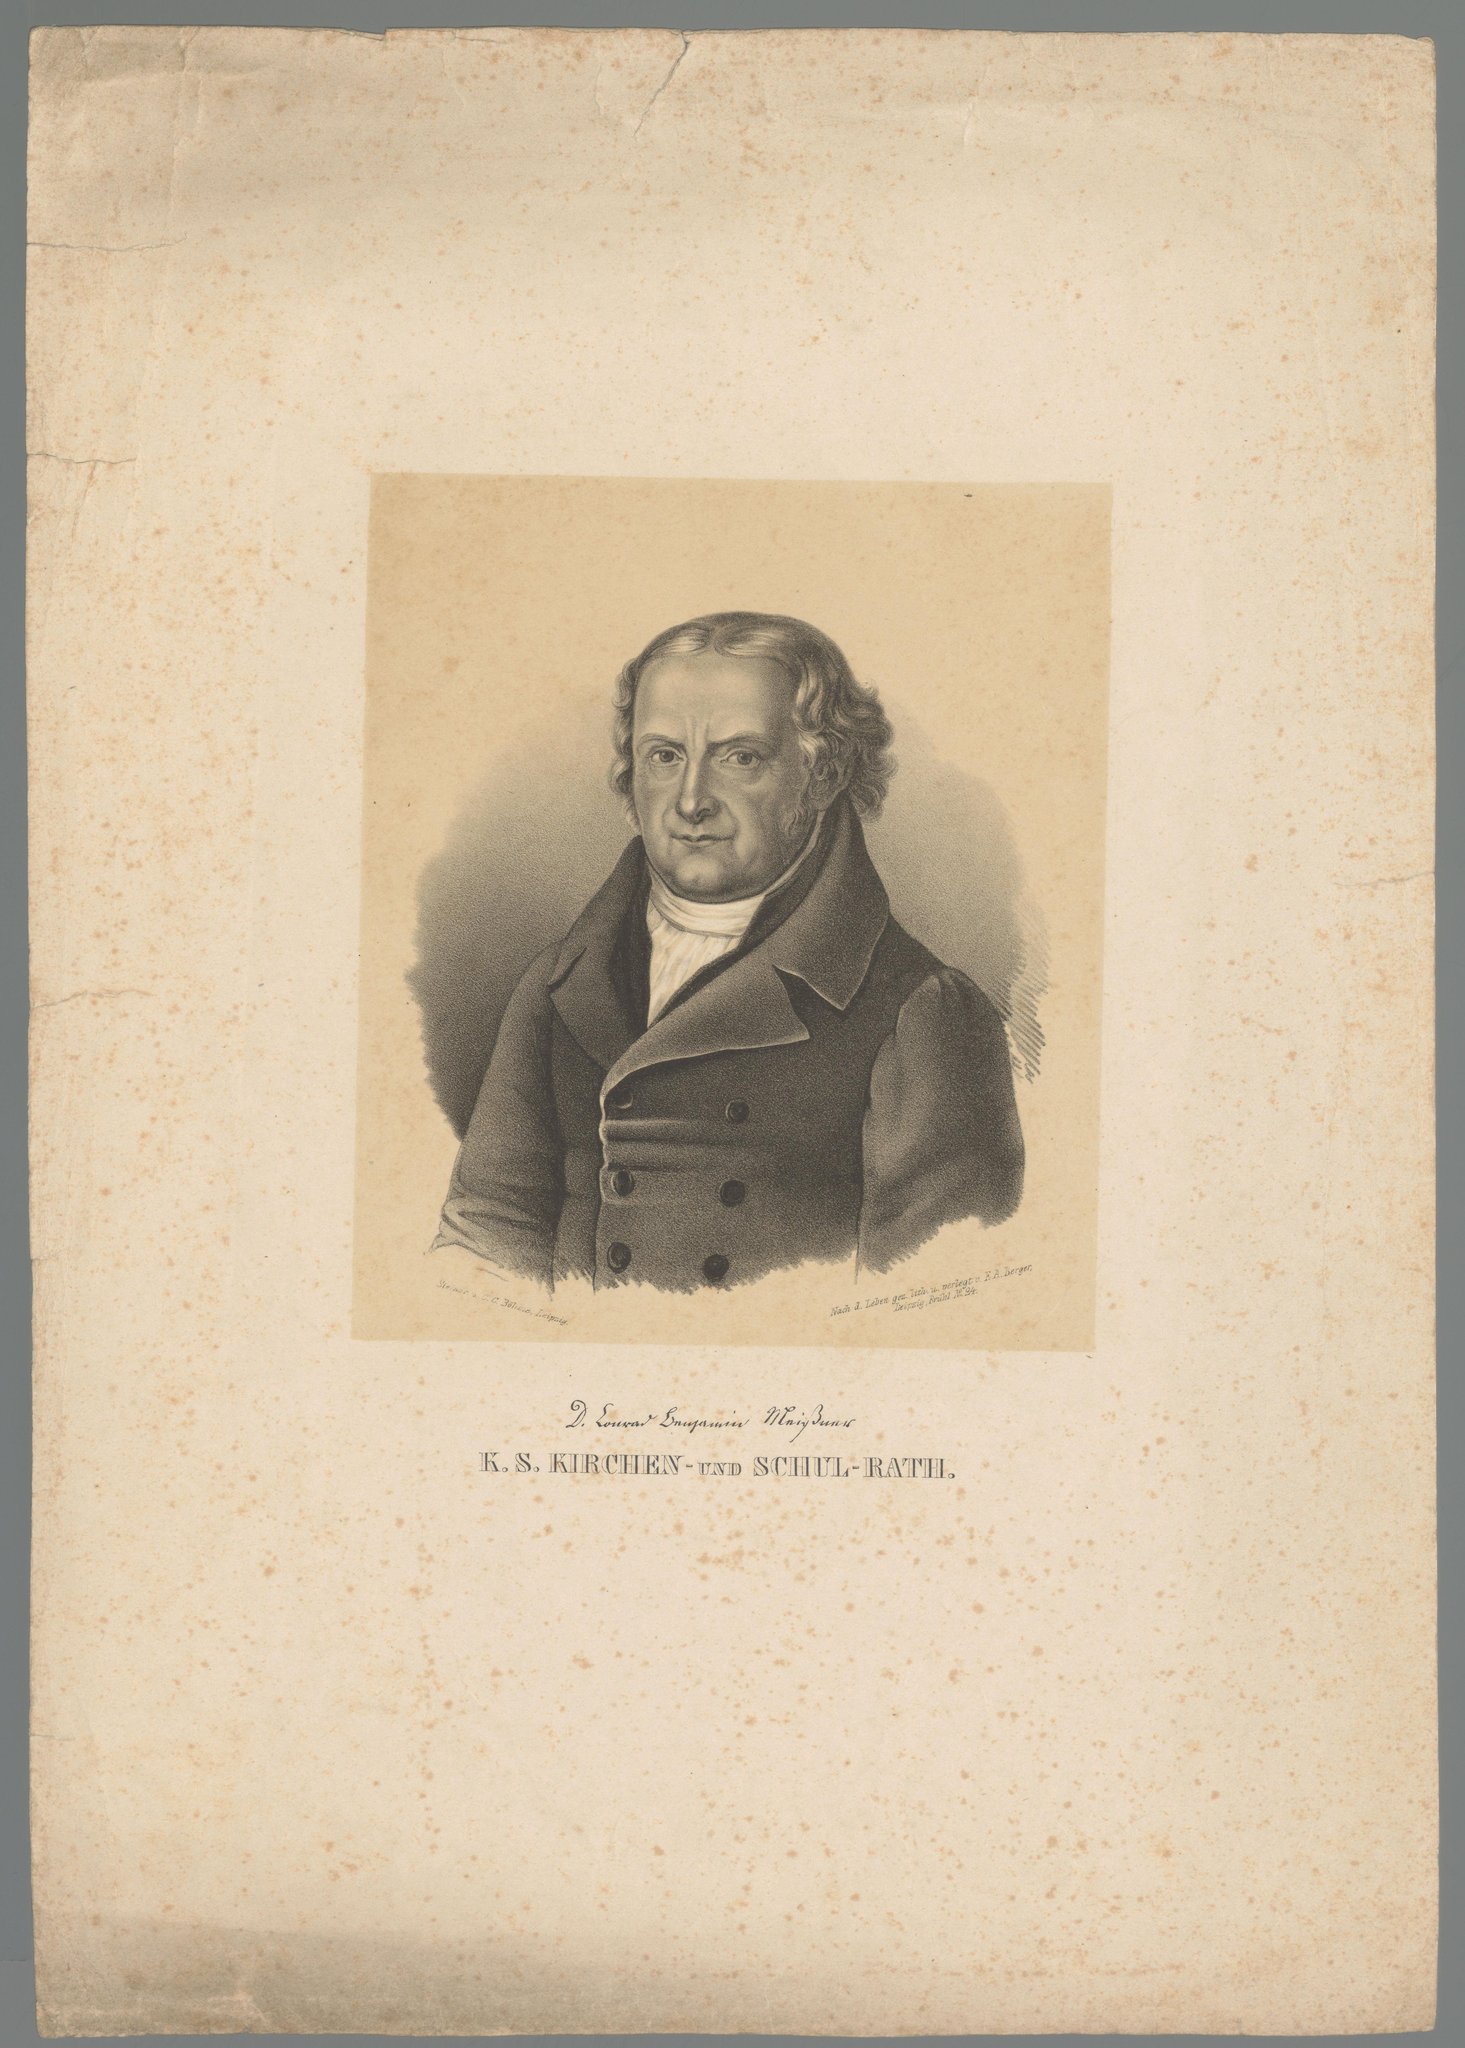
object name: print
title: D. Konrad Benjamin Meissner K.S. Kirchen- und Schul-Rath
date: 1825-1875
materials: paper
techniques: tone lithography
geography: leipzig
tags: adult man, historical persons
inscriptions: collector's mark: Lugt 2228